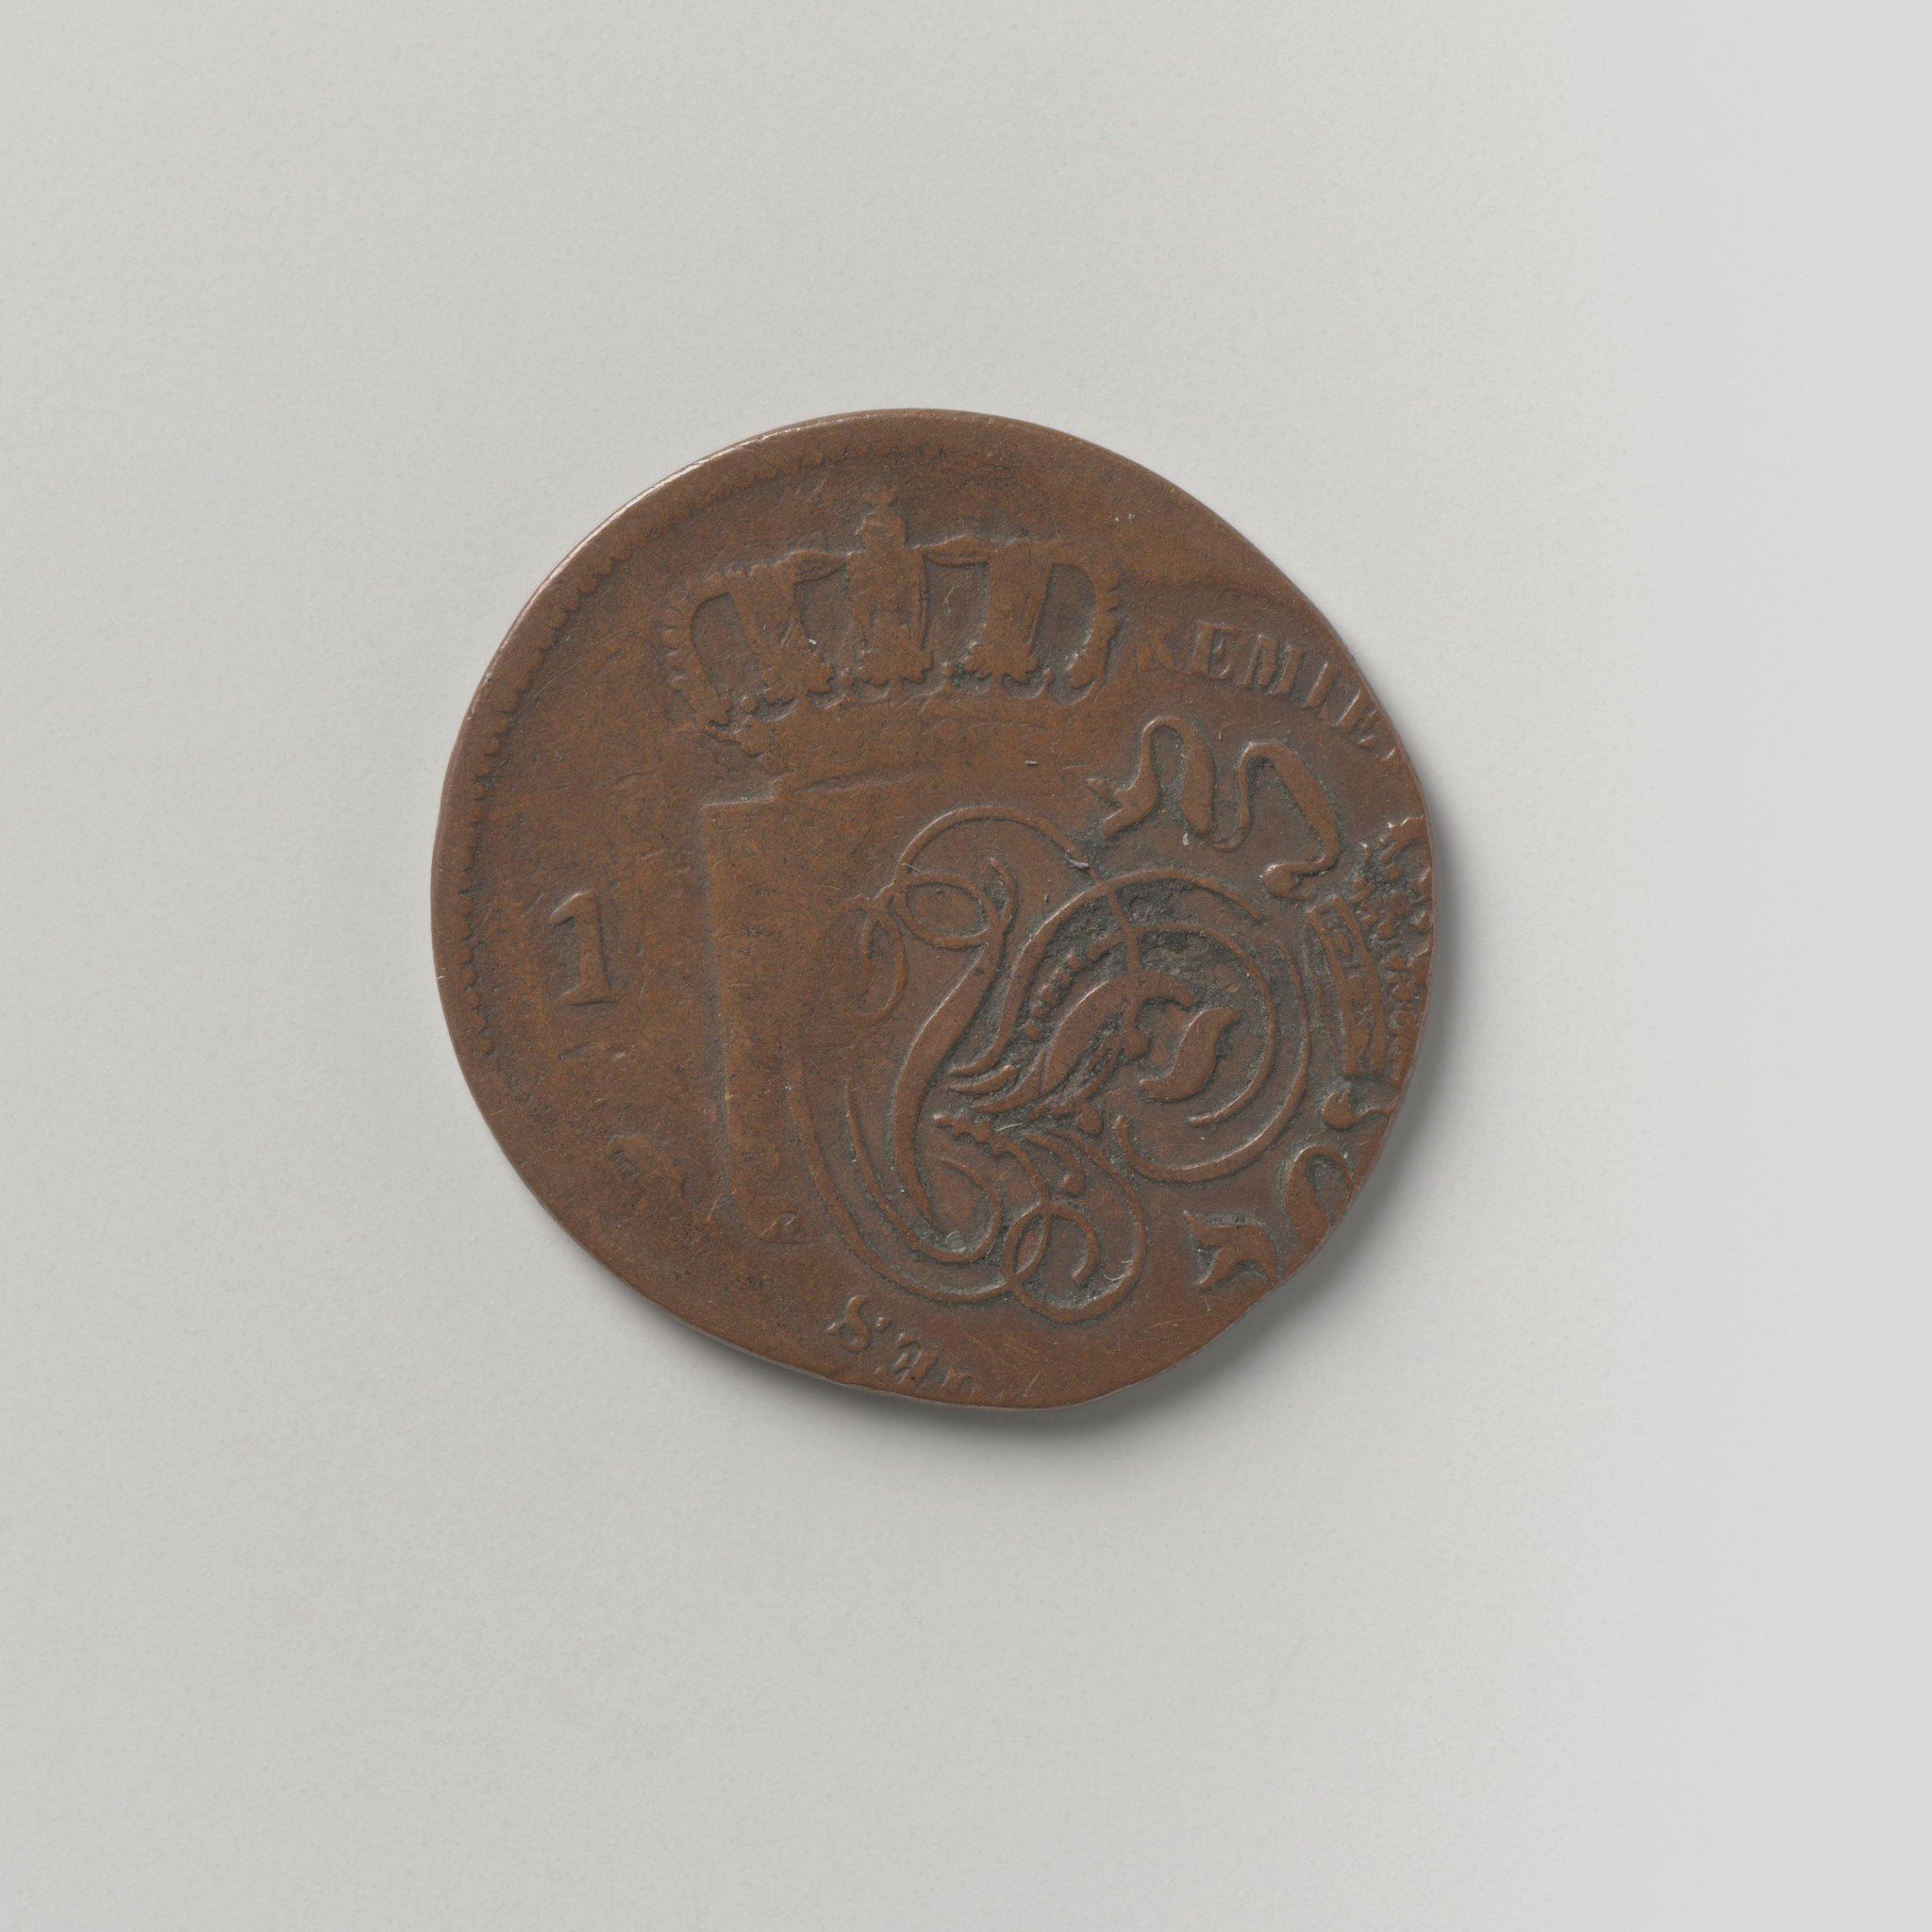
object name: twee centime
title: België, Leopold I, 2 centimes, 1833, op muntplaatje van Nederlandse cent.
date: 1833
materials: copper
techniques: striking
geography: brussels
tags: laeken, leopold i (koning der belgen)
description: Koperen munt. Gedeelte van beeldenaar. Voorzijde: zittende, omkijkende leeuw naar links met onder rechter klauw paneel met opschrift. In afsnede waarde-aanduiding. Keerzijde: gekroond monogram. Jaartal onderaan. Op muntplaatje van Nederlandse cent.